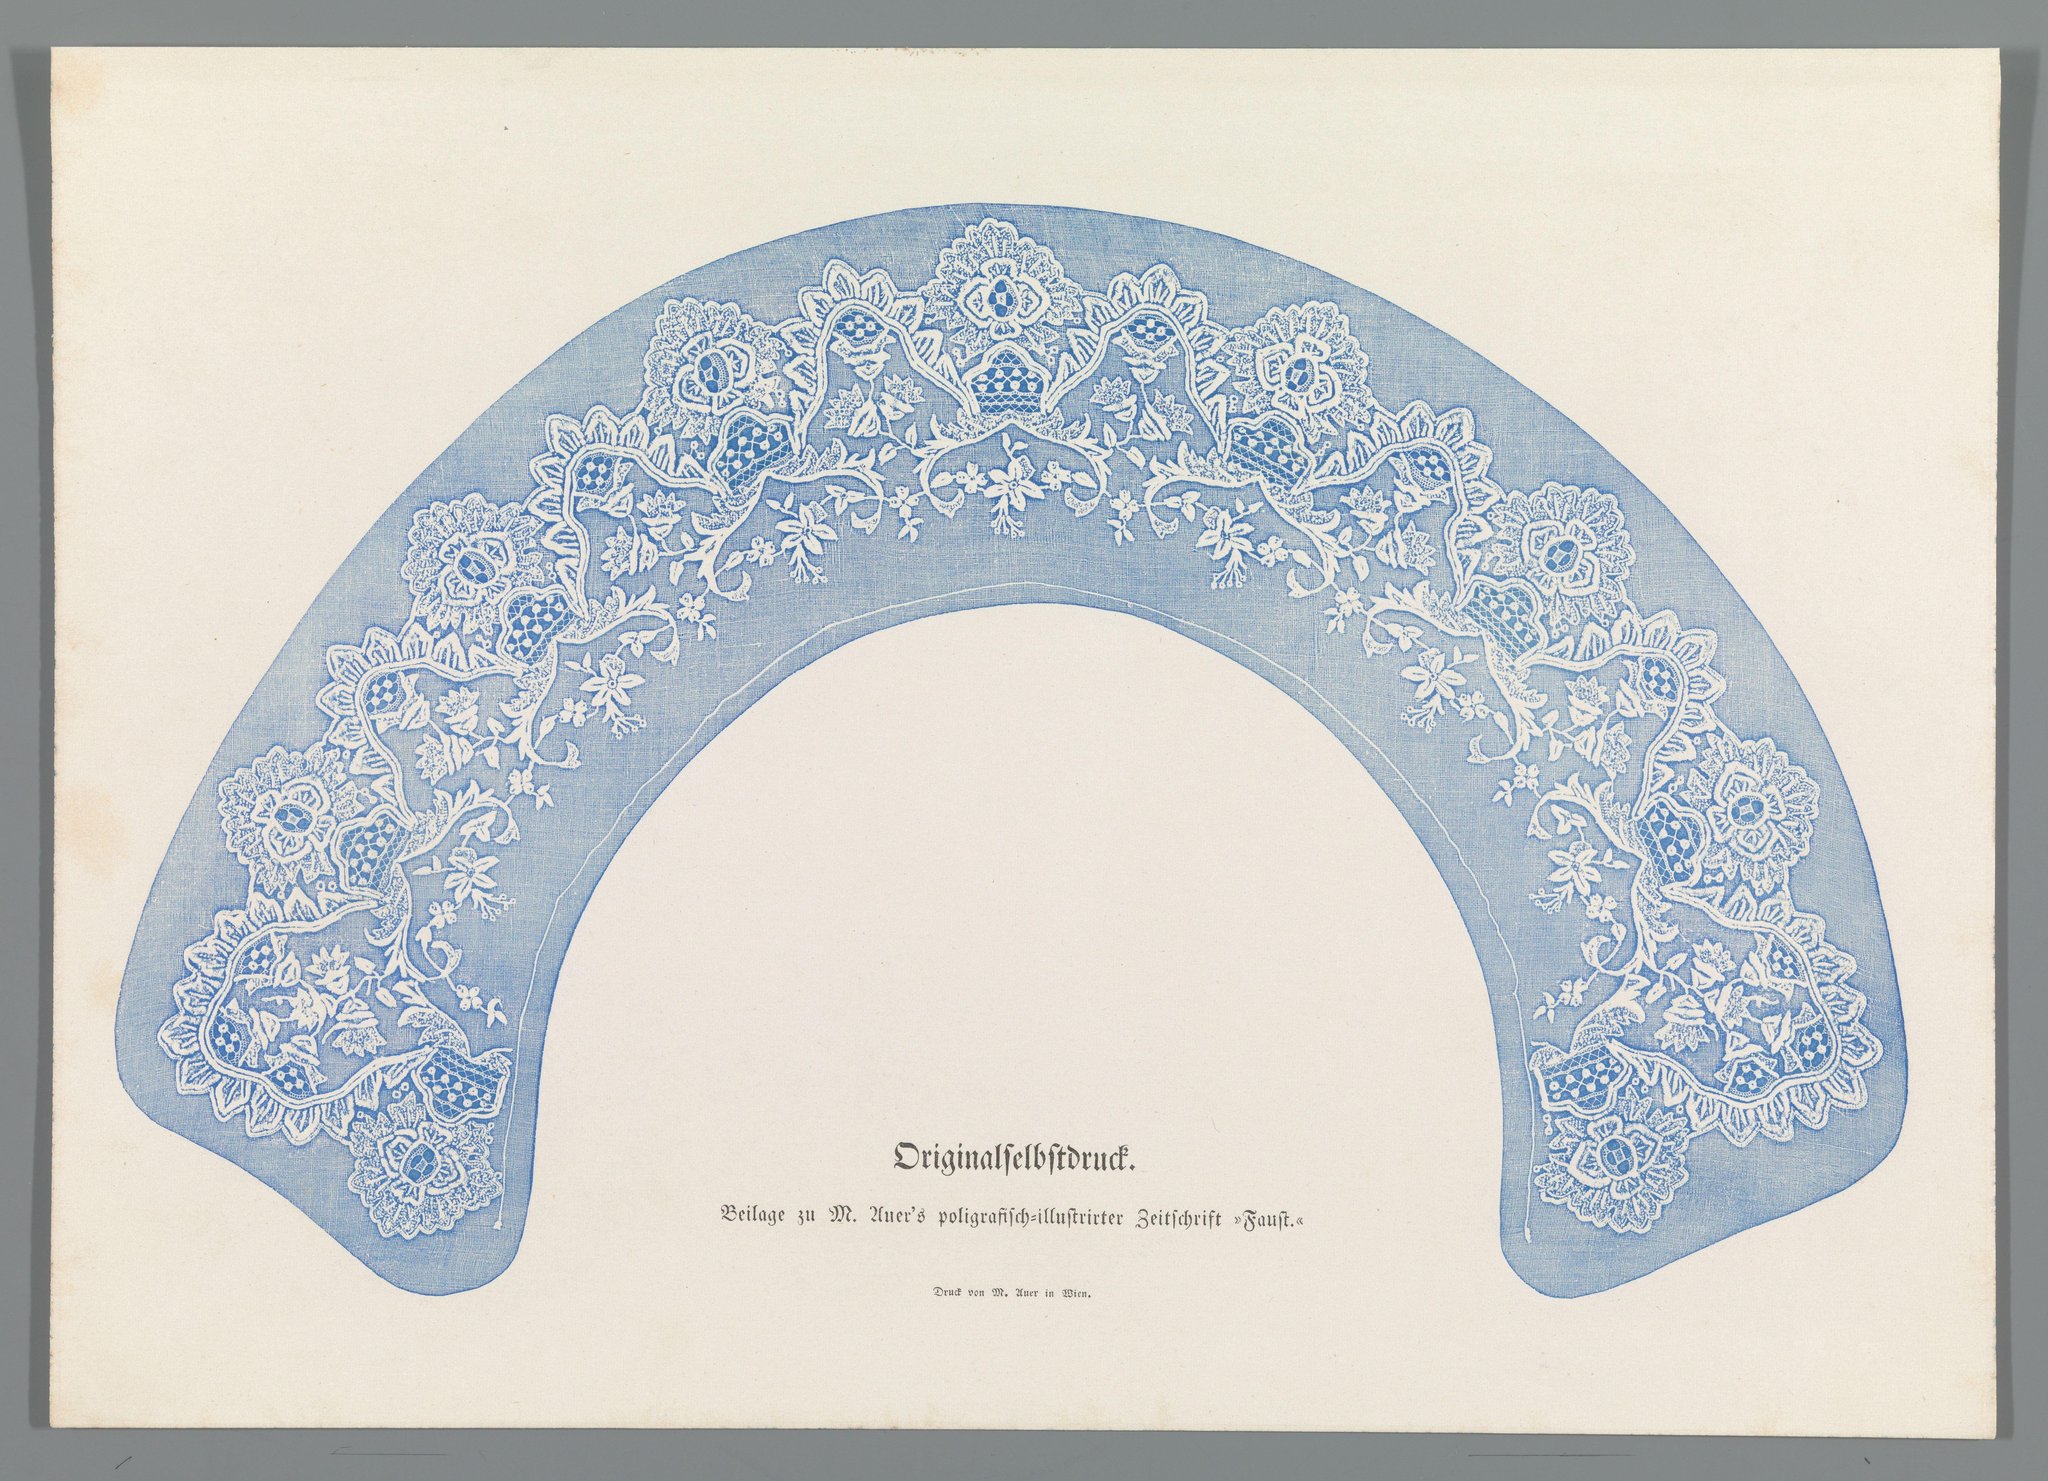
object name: print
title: Kantpatroon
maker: alois ritter von auer von welsbach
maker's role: printer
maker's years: 1813-1869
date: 1855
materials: paper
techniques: nature print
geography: vienna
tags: lace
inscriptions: inscription: ‘Originalselbstdruck./ Beilage zu M. Auer's poligrafisch-illustrirter Zeitschrift "Faust."’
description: Blad uit reeks van 12 Naturselbstdrucke Auer.